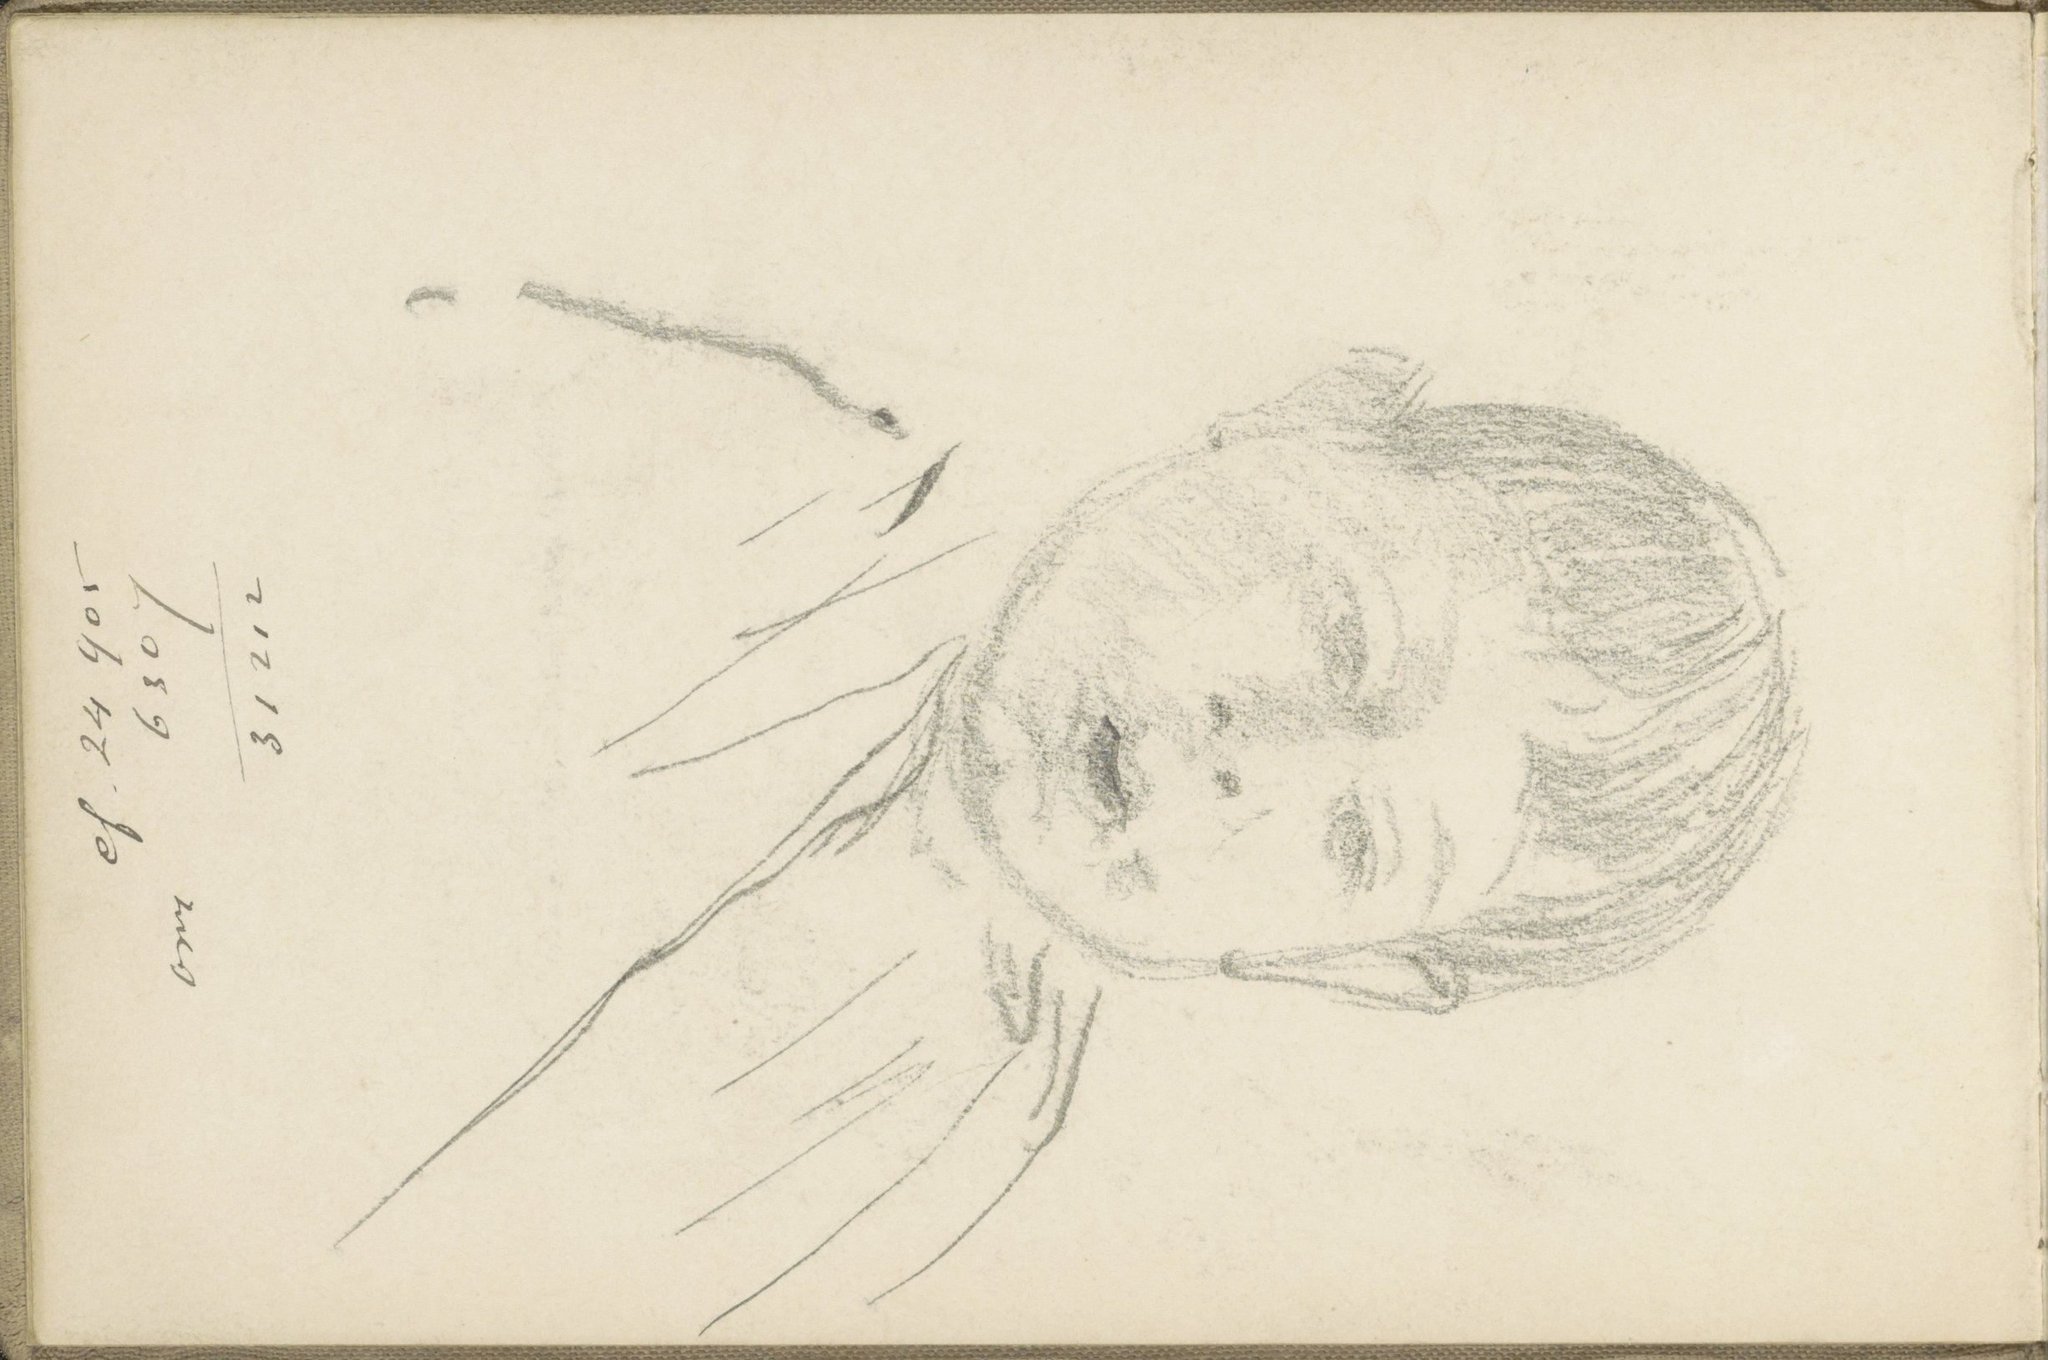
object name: sketchbook leaf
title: Portret van een jongen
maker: carel adolph lion cachet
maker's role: draughtsman, print maker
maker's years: 1864-1945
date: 1905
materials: paper, pencil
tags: head (human), boy (child between toddler and youth)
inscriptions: annotation: ‘[...]’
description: Blad 6 verso uit een schetsboek met 27 bladen.